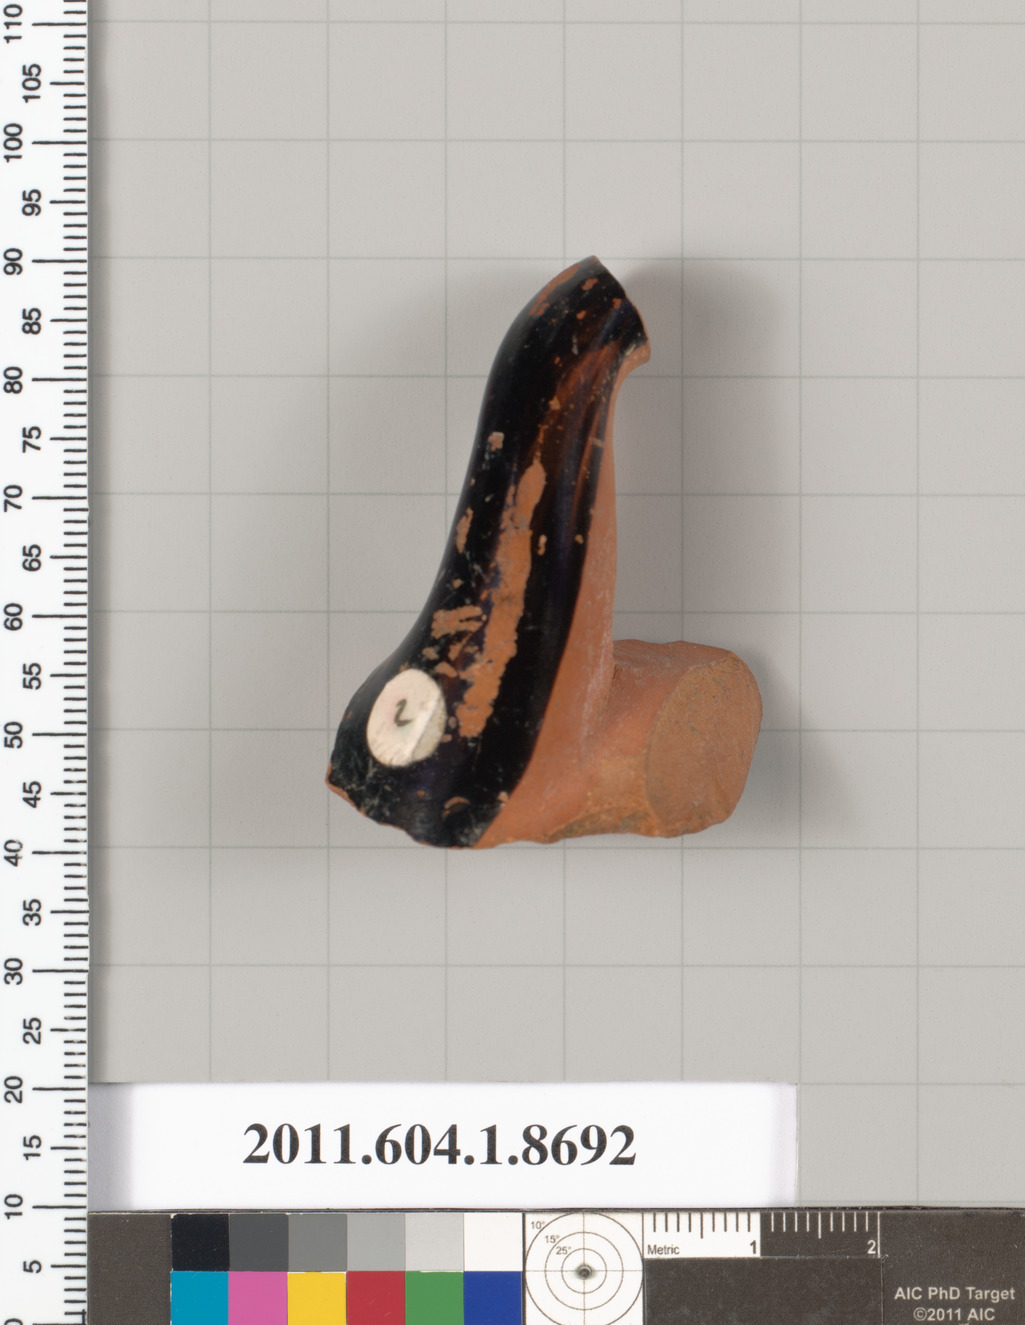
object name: kylix fragment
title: Terracotta fragment of a stemless kylix (drinking cup)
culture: greek, attic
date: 470-450 BCE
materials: terracotta